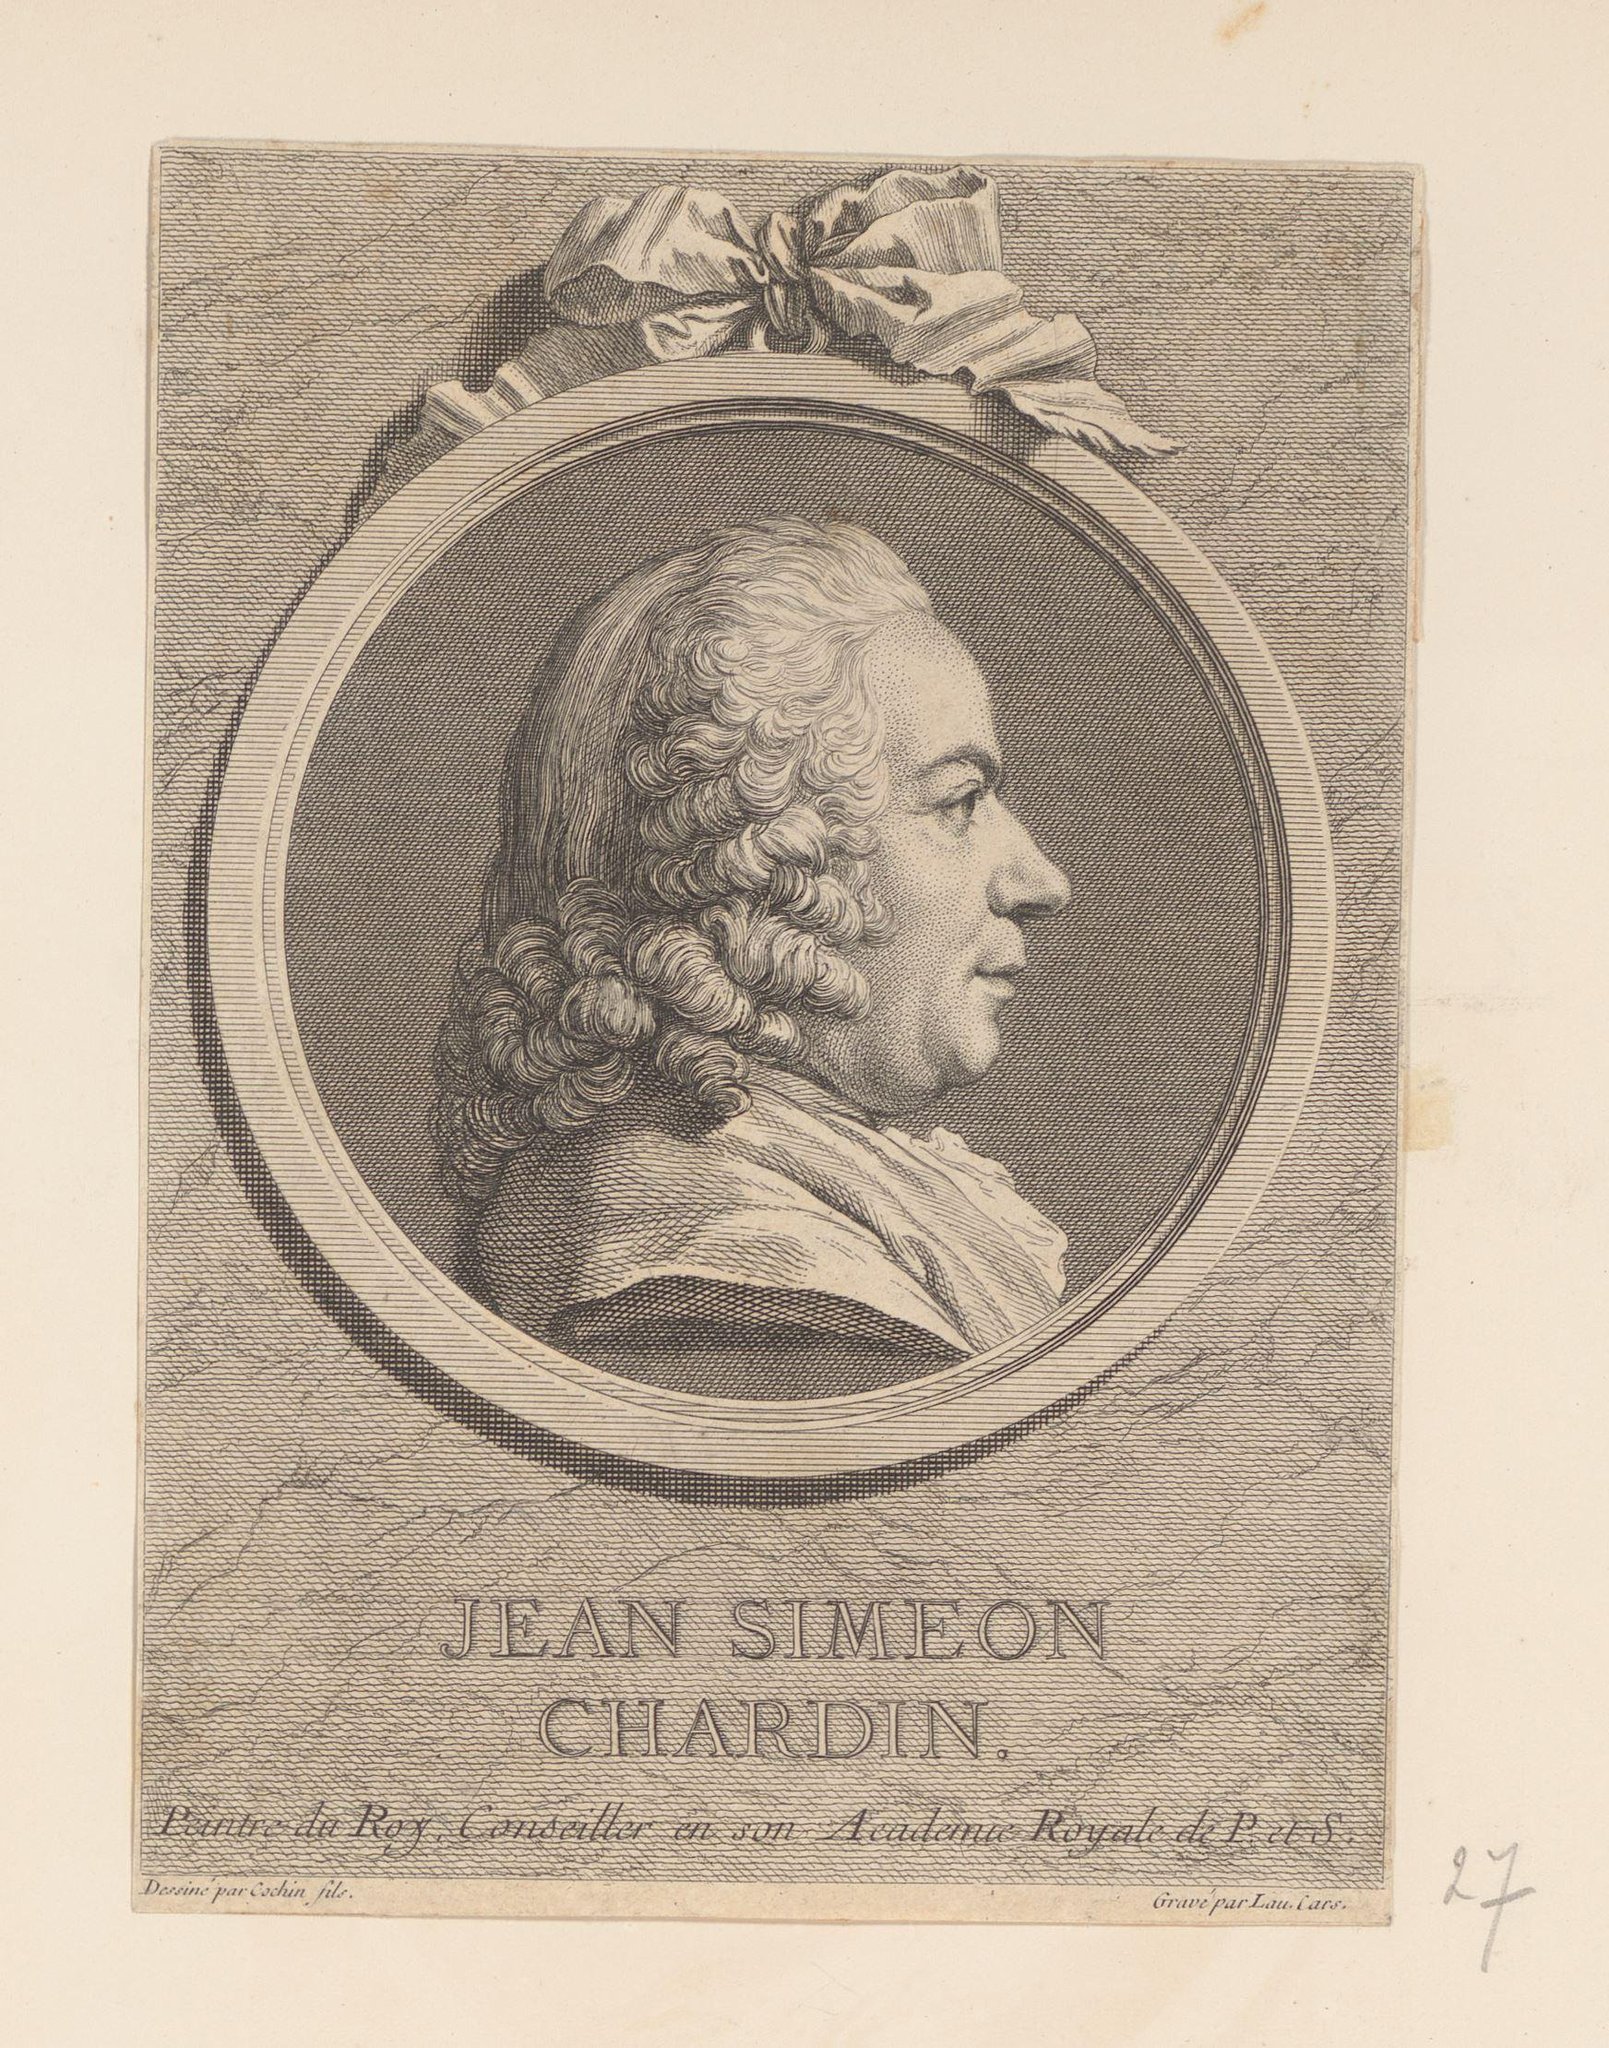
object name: album leaf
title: Jean Simeon Chardin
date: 1740-1771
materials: paper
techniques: engraving, etching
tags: draughtsman, jean baptiste siméon chardin, historical persons, portrait, self-portrait of painter